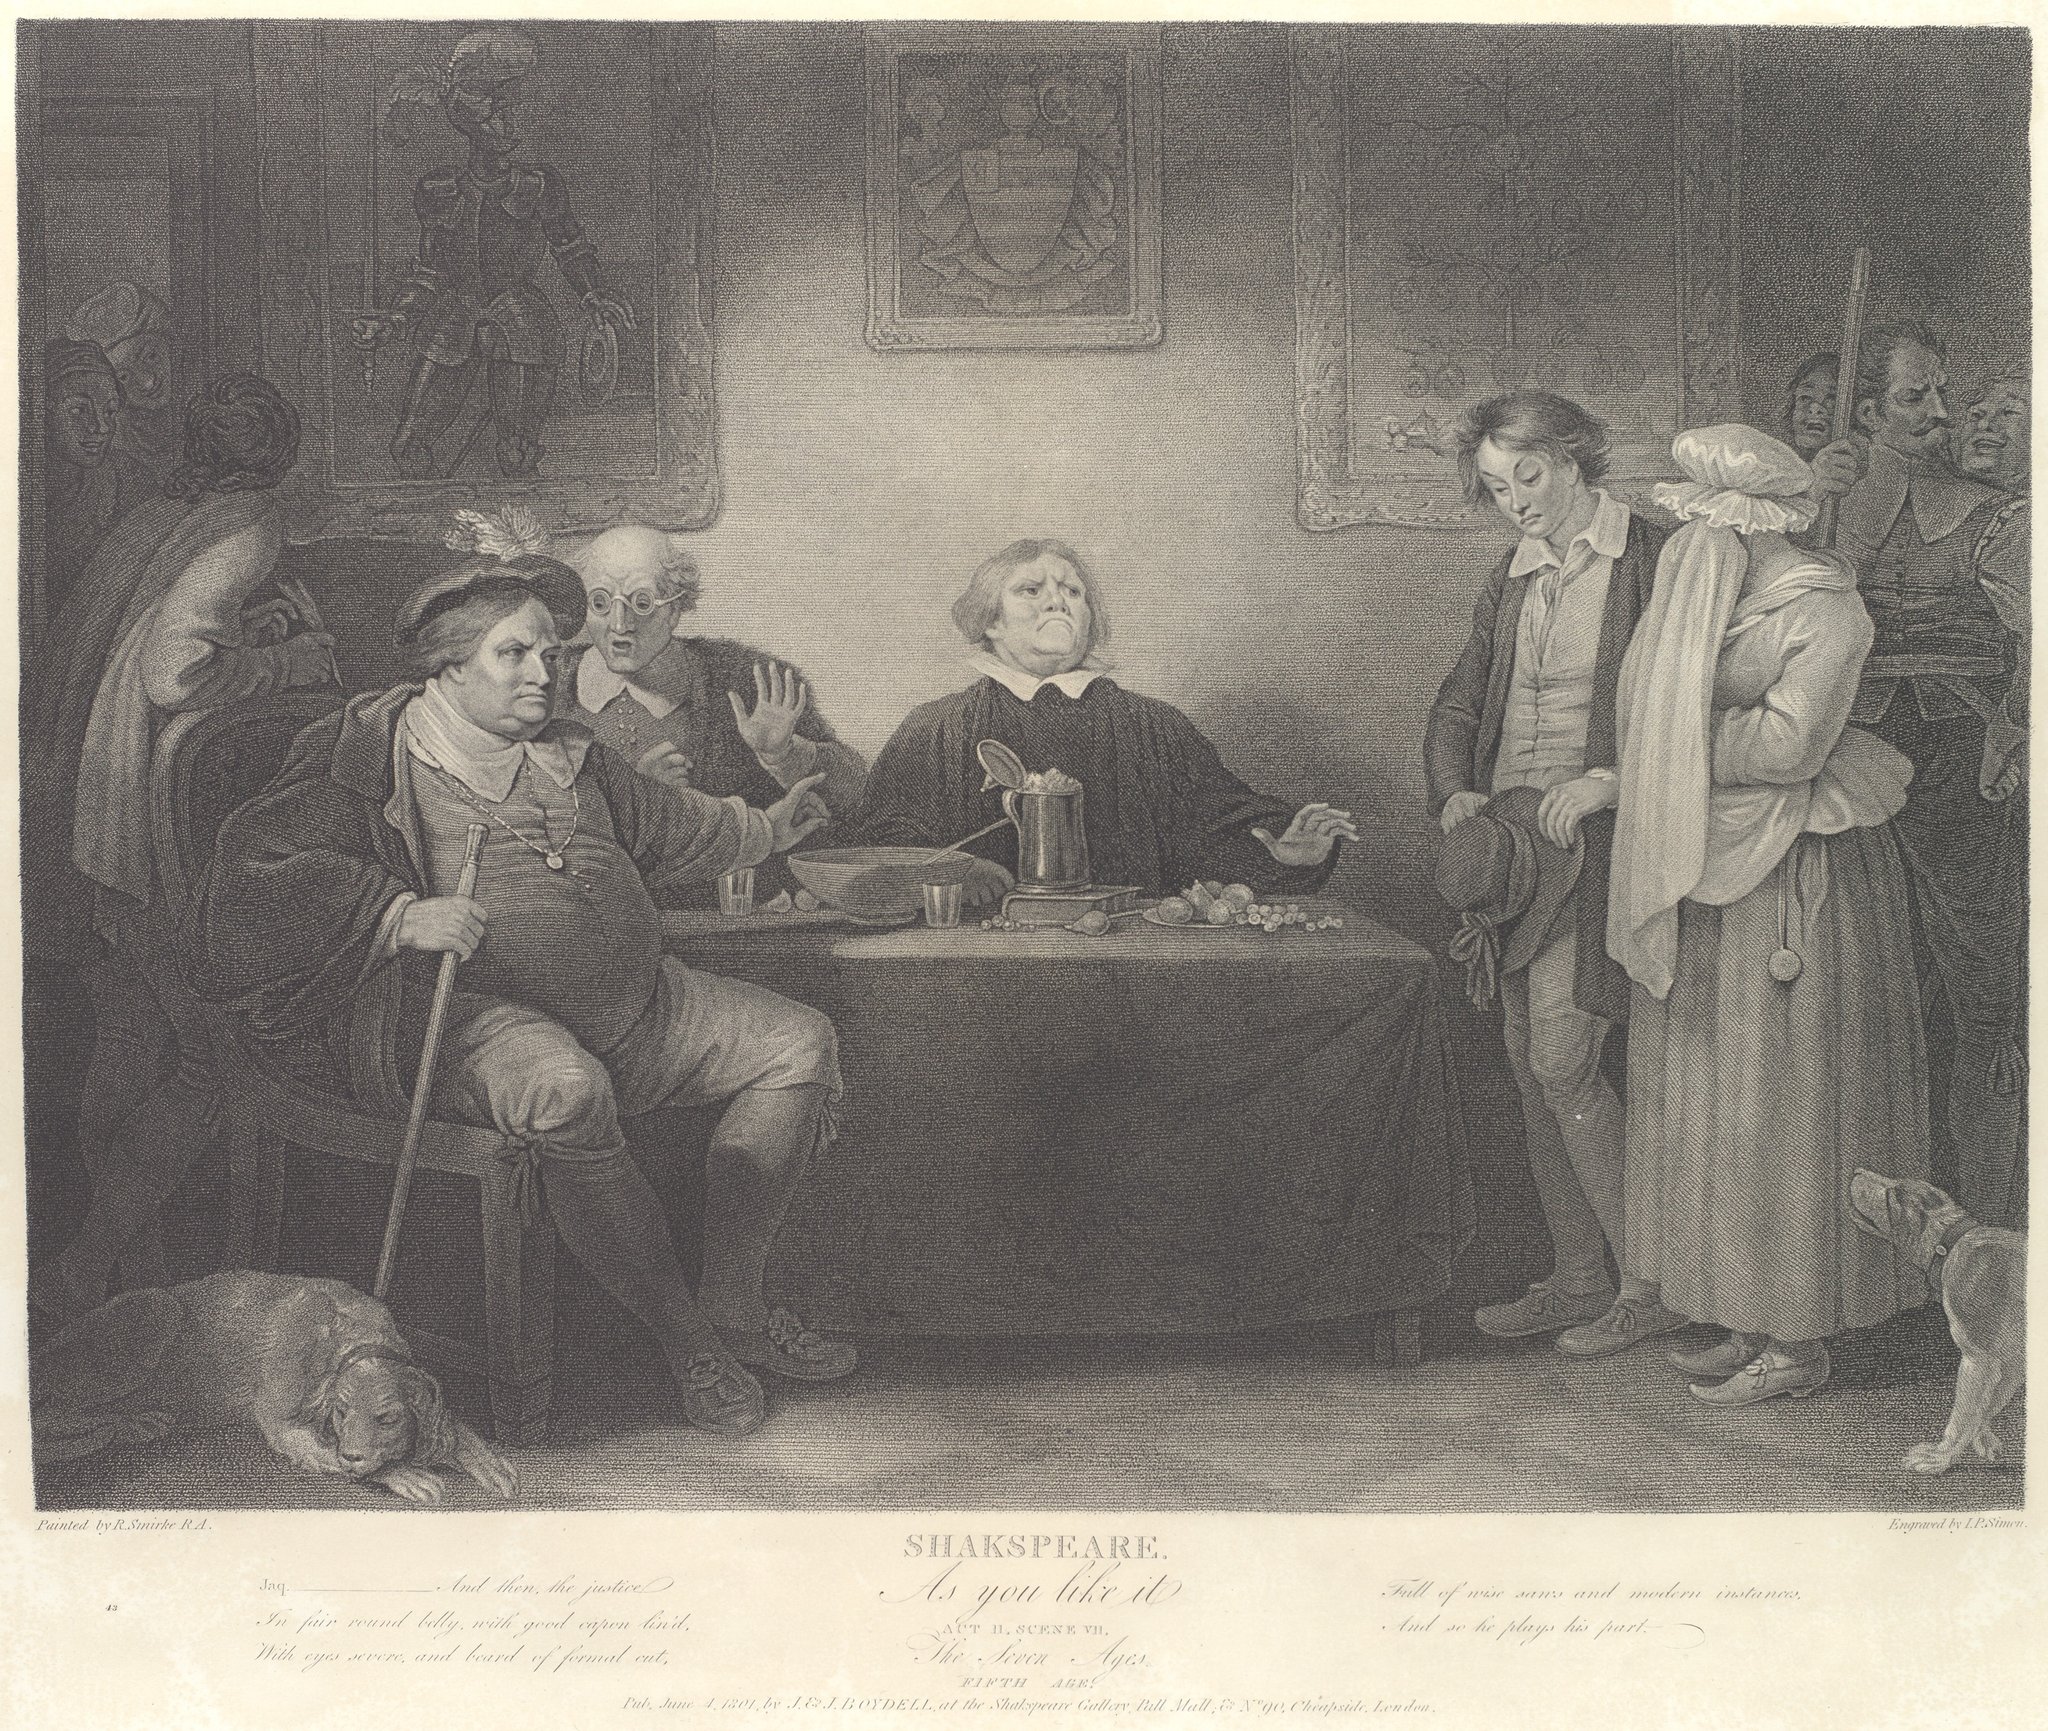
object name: print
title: The Seven Ages, Fifth Age: The Justice (Shakespeare, As You Like It, Act 2, Scene 7)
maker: peter simon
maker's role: engraver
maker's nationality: british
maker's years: 1764-1813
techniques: engraving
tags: shakespeare,men,women,dogs